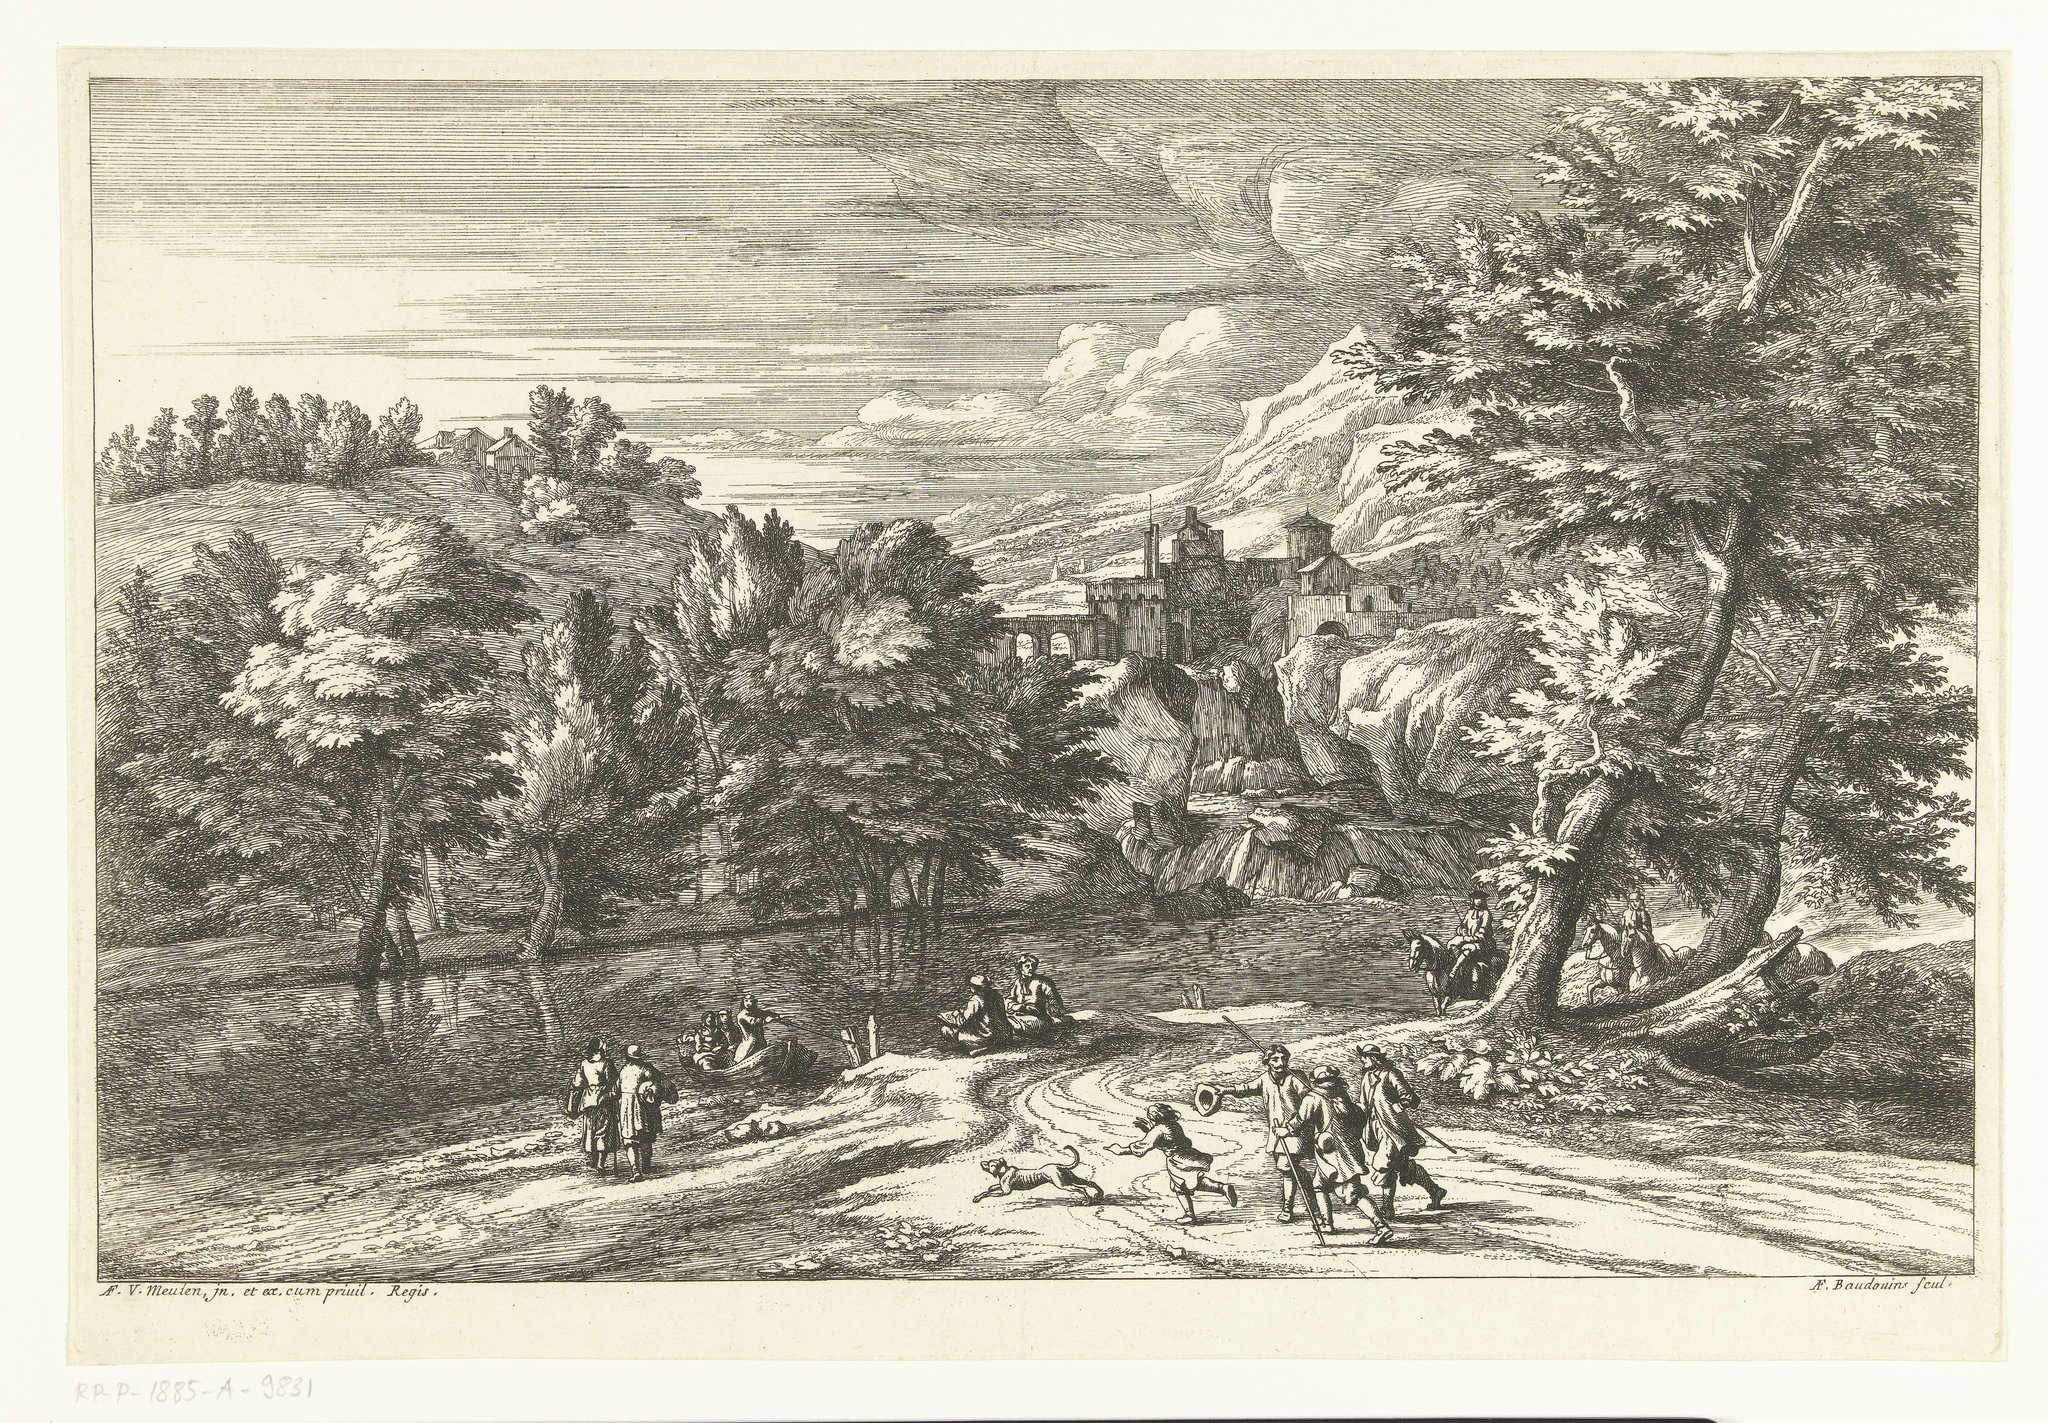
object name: print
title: Landschappen met reizigers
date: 1666-1674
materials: paper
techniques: etching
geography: paris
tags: river (+ landscape with figures, staffage)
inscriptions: collector's mark: Lugt 2228